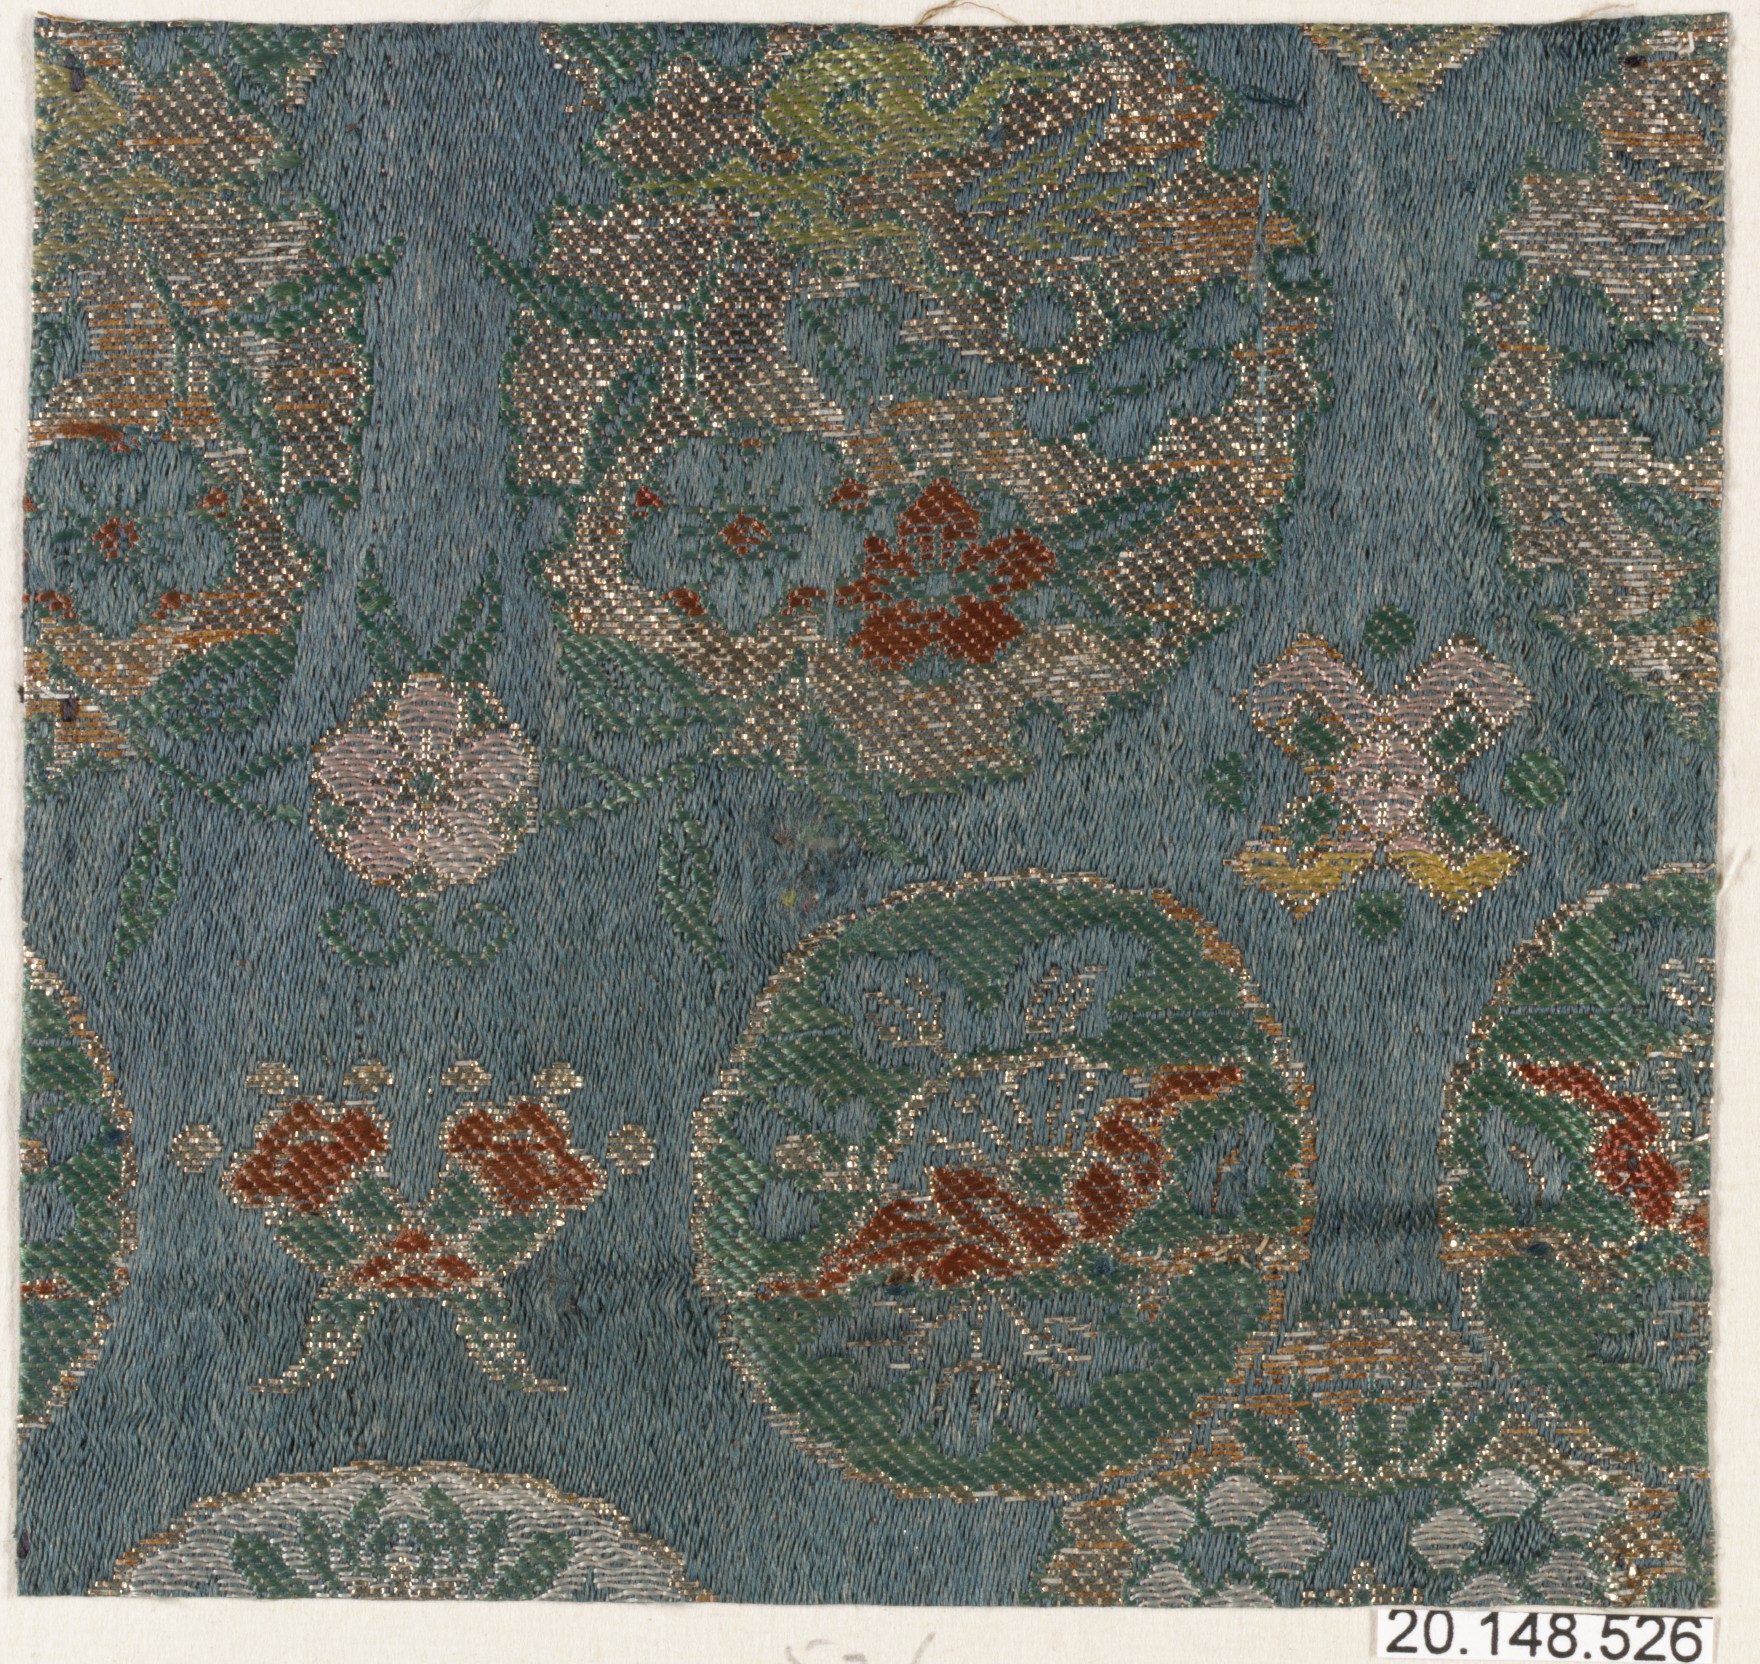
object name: piece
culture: japanese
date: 1701-1800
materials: silk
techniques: compound weave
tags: flowers